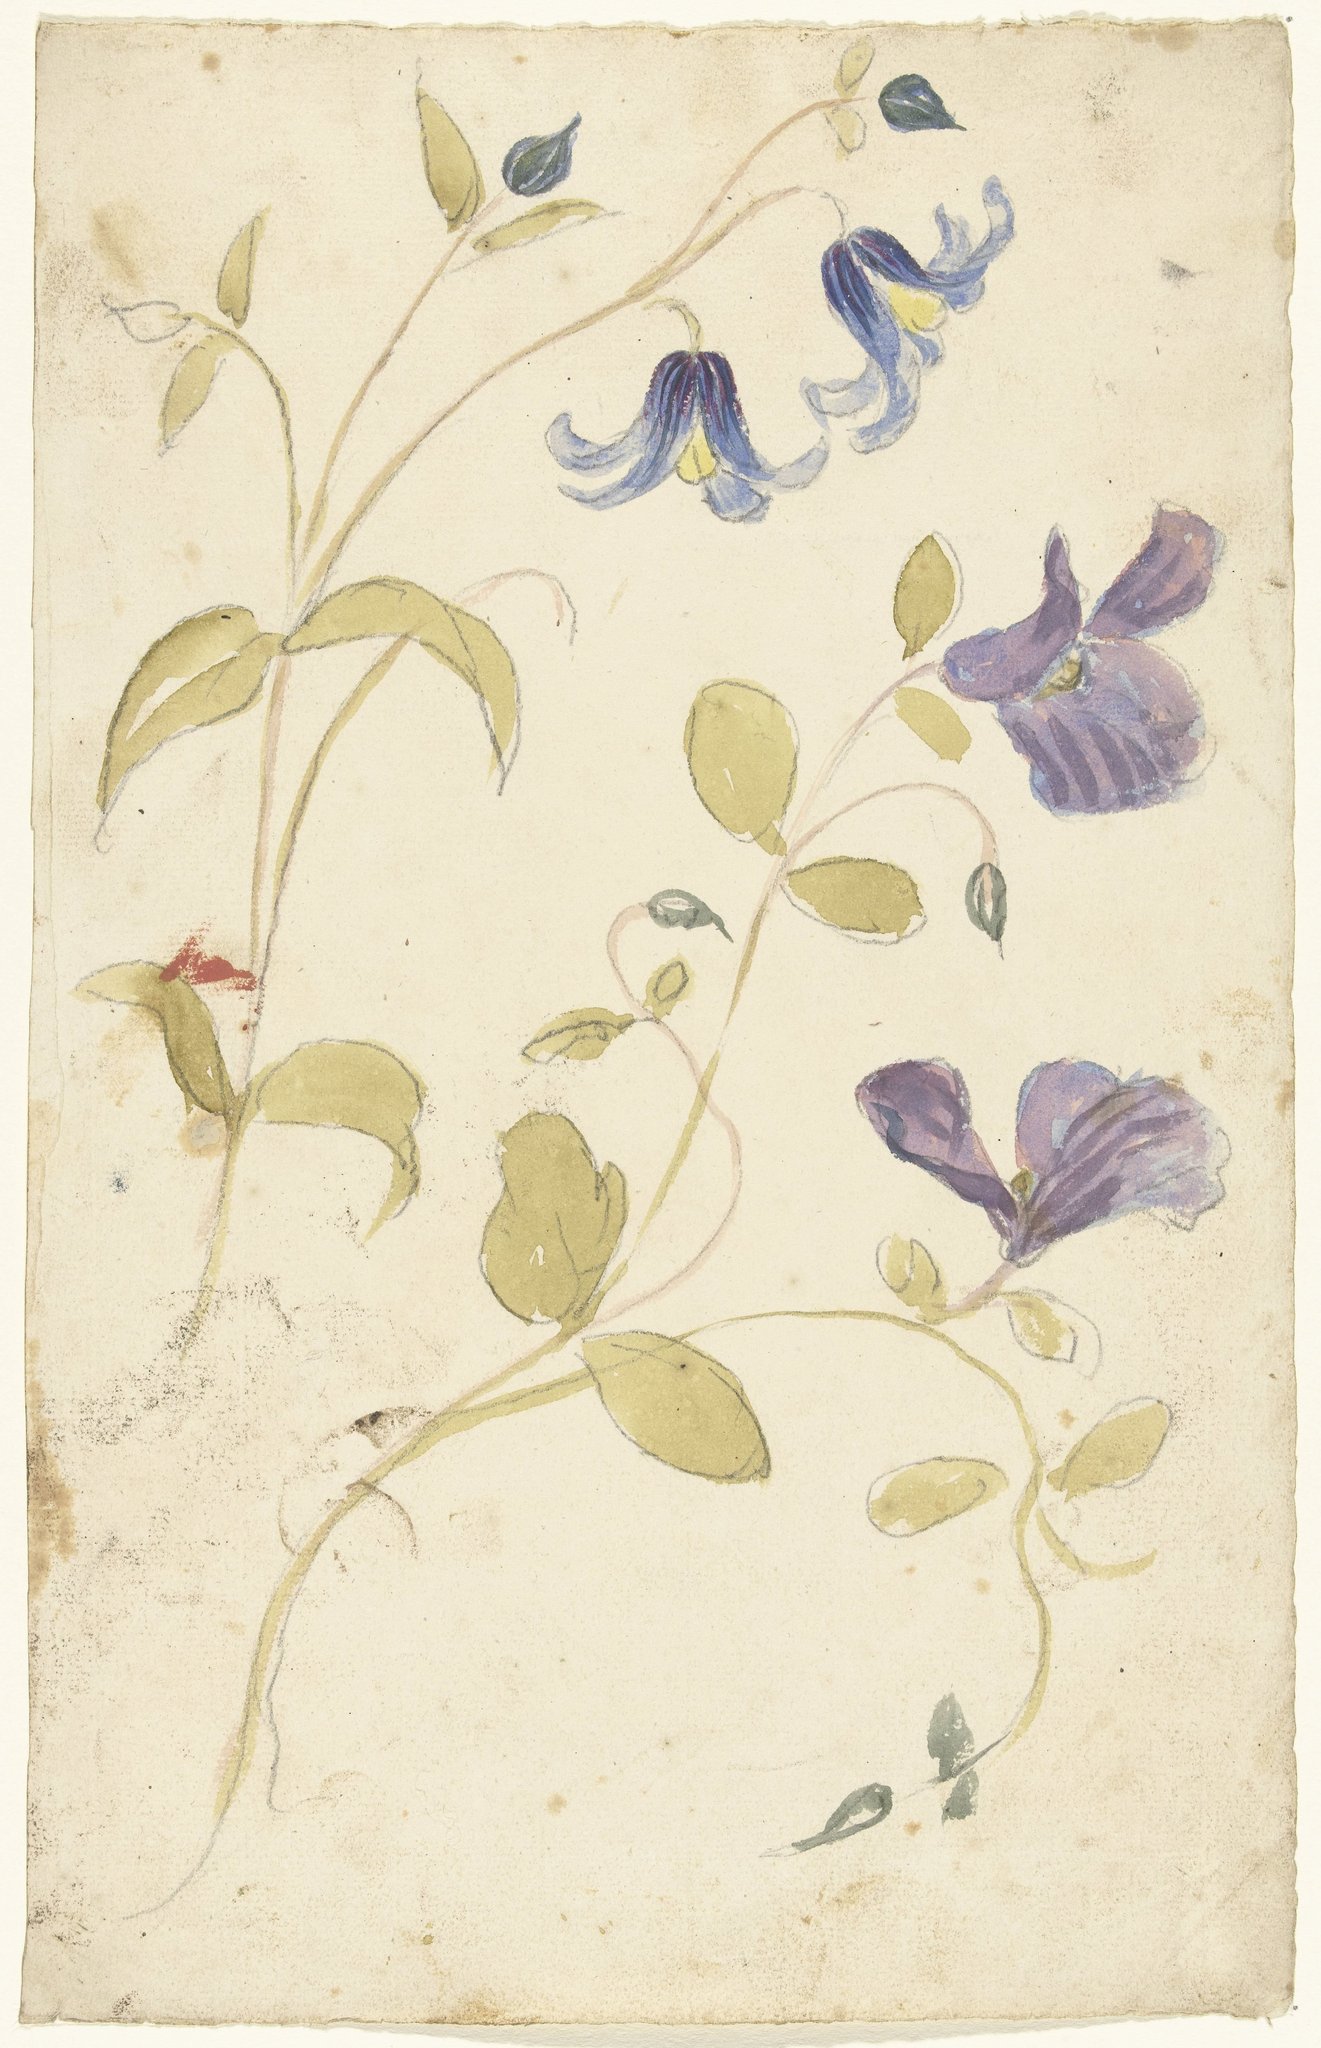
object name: watercolor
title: Studies of Purple and Blue Flowers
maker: elias van nijmegen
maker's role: draughtsman, painter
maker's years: 1667-1755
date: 1700-1725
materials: paper, pencil, watercolor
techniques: brush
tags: flowers